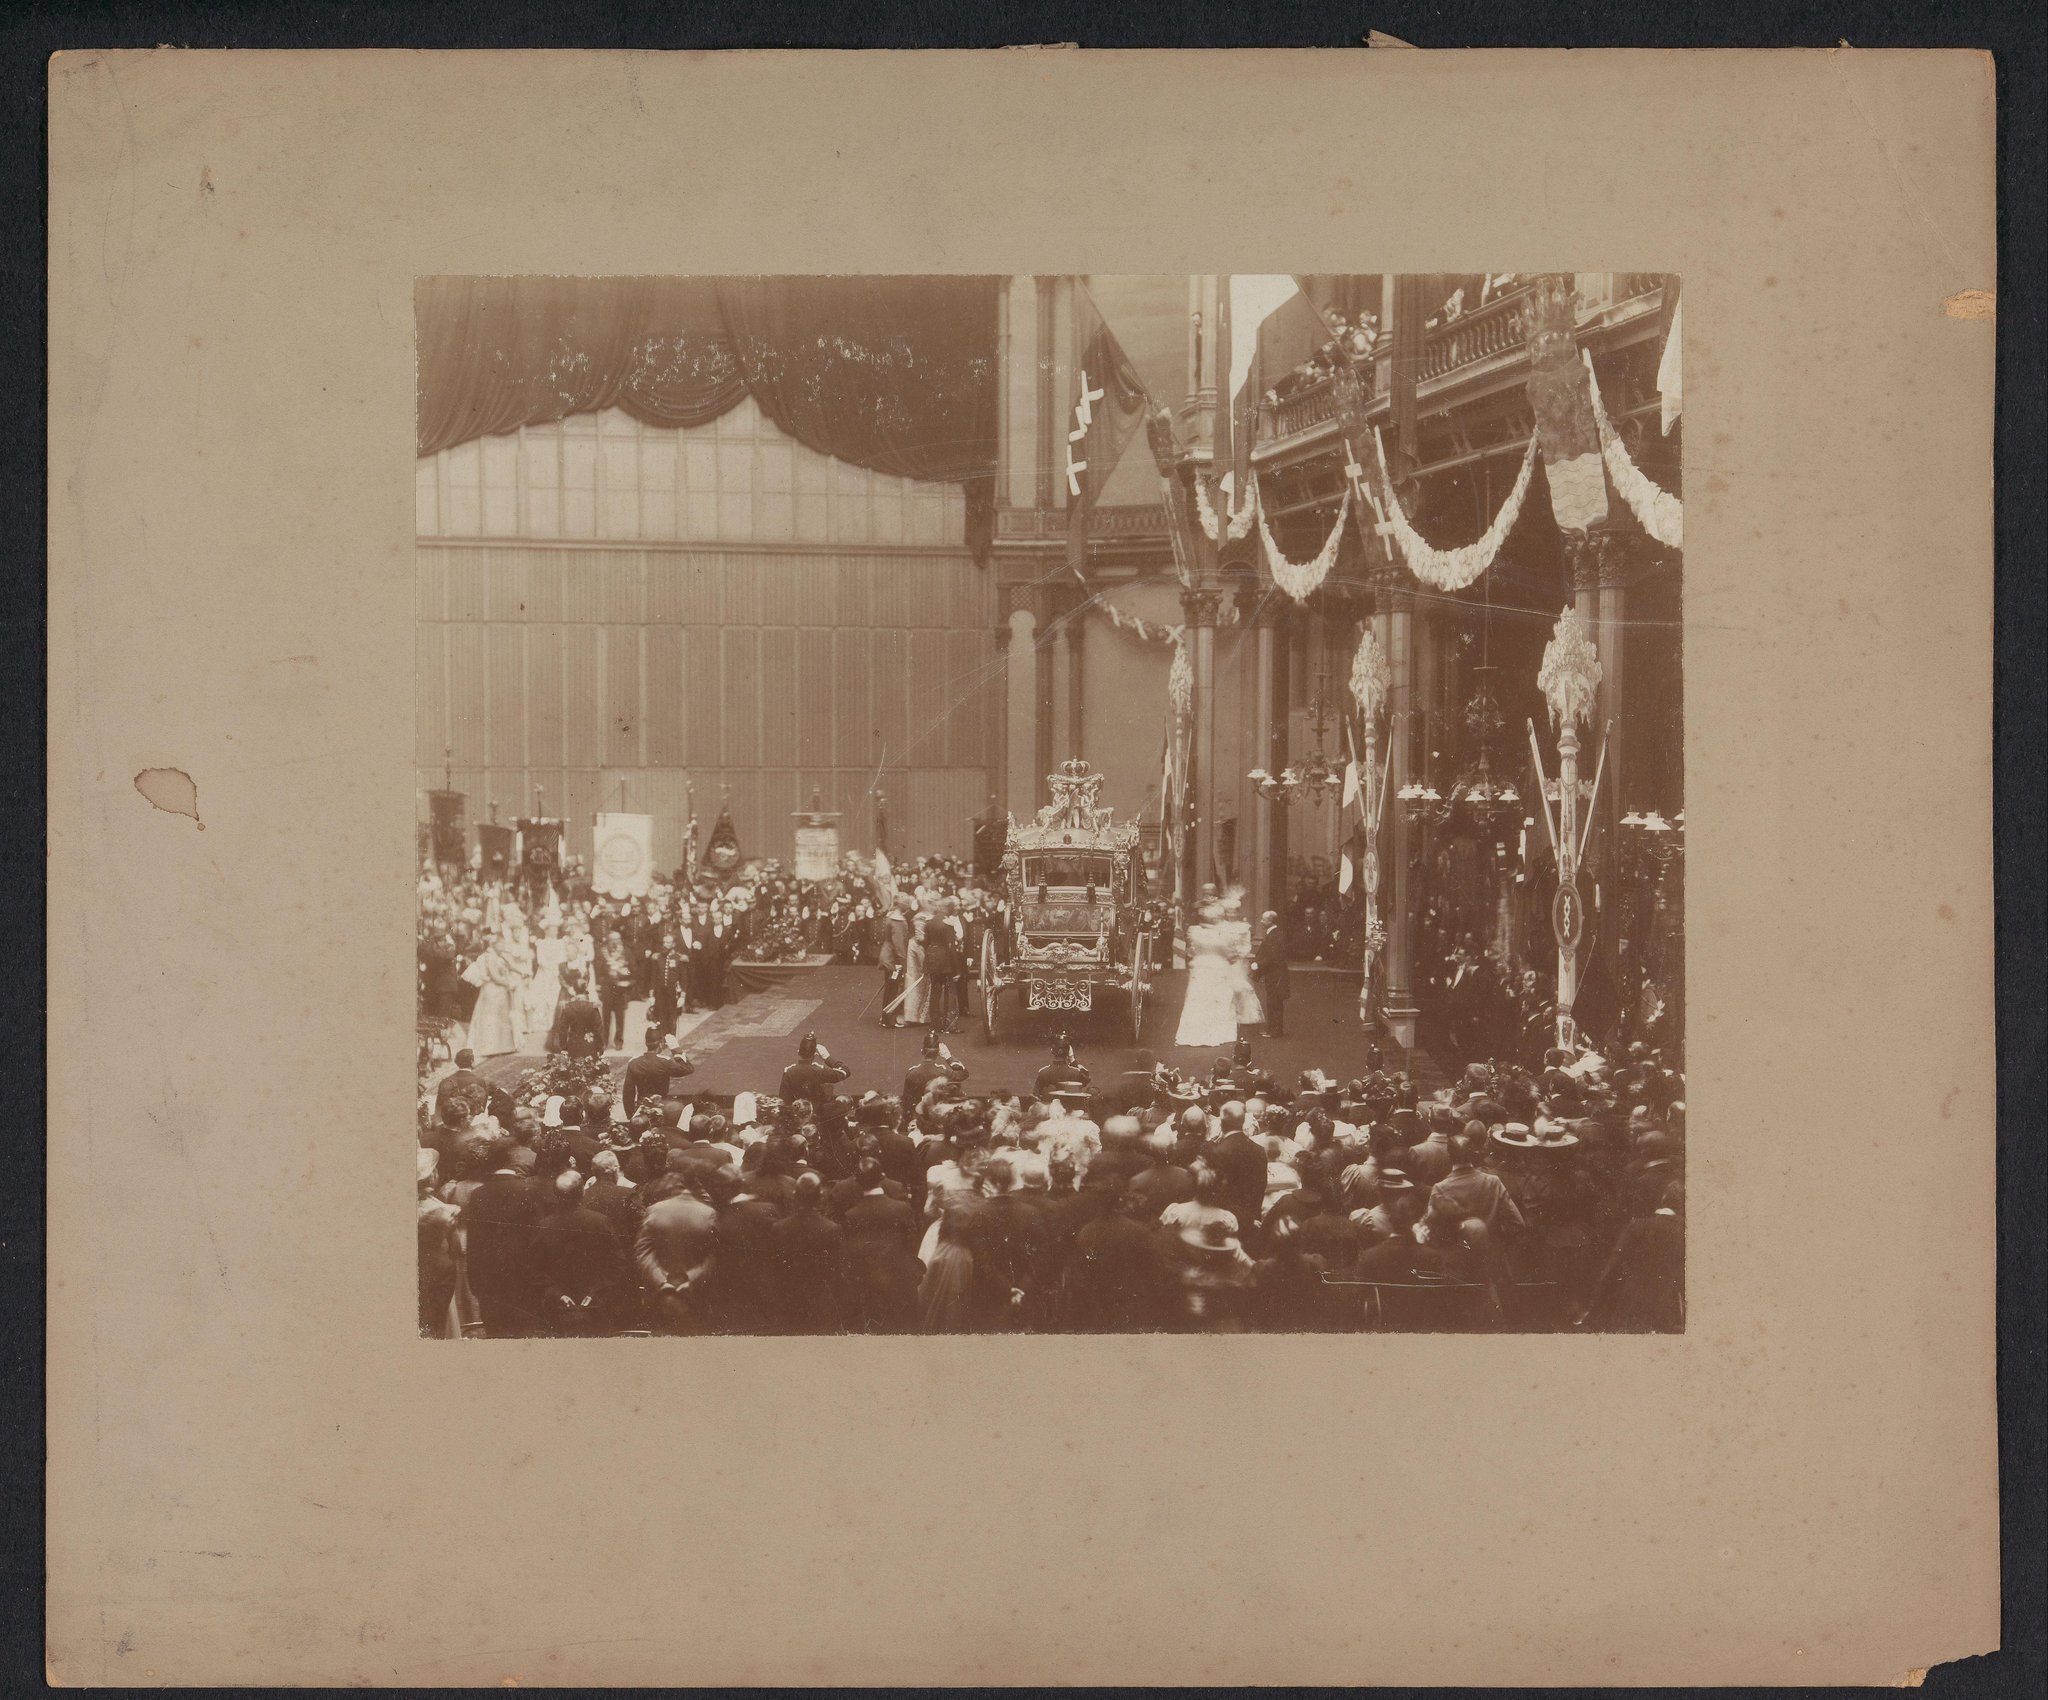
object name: photograph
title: Ingebruikneming van de Gouden Koets[onz]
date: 1898-1902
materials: cardboard, photographic support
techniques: albumen print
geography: amsterdam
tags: the hague, print maker, wilhelmina of the netherlands, amsterdam